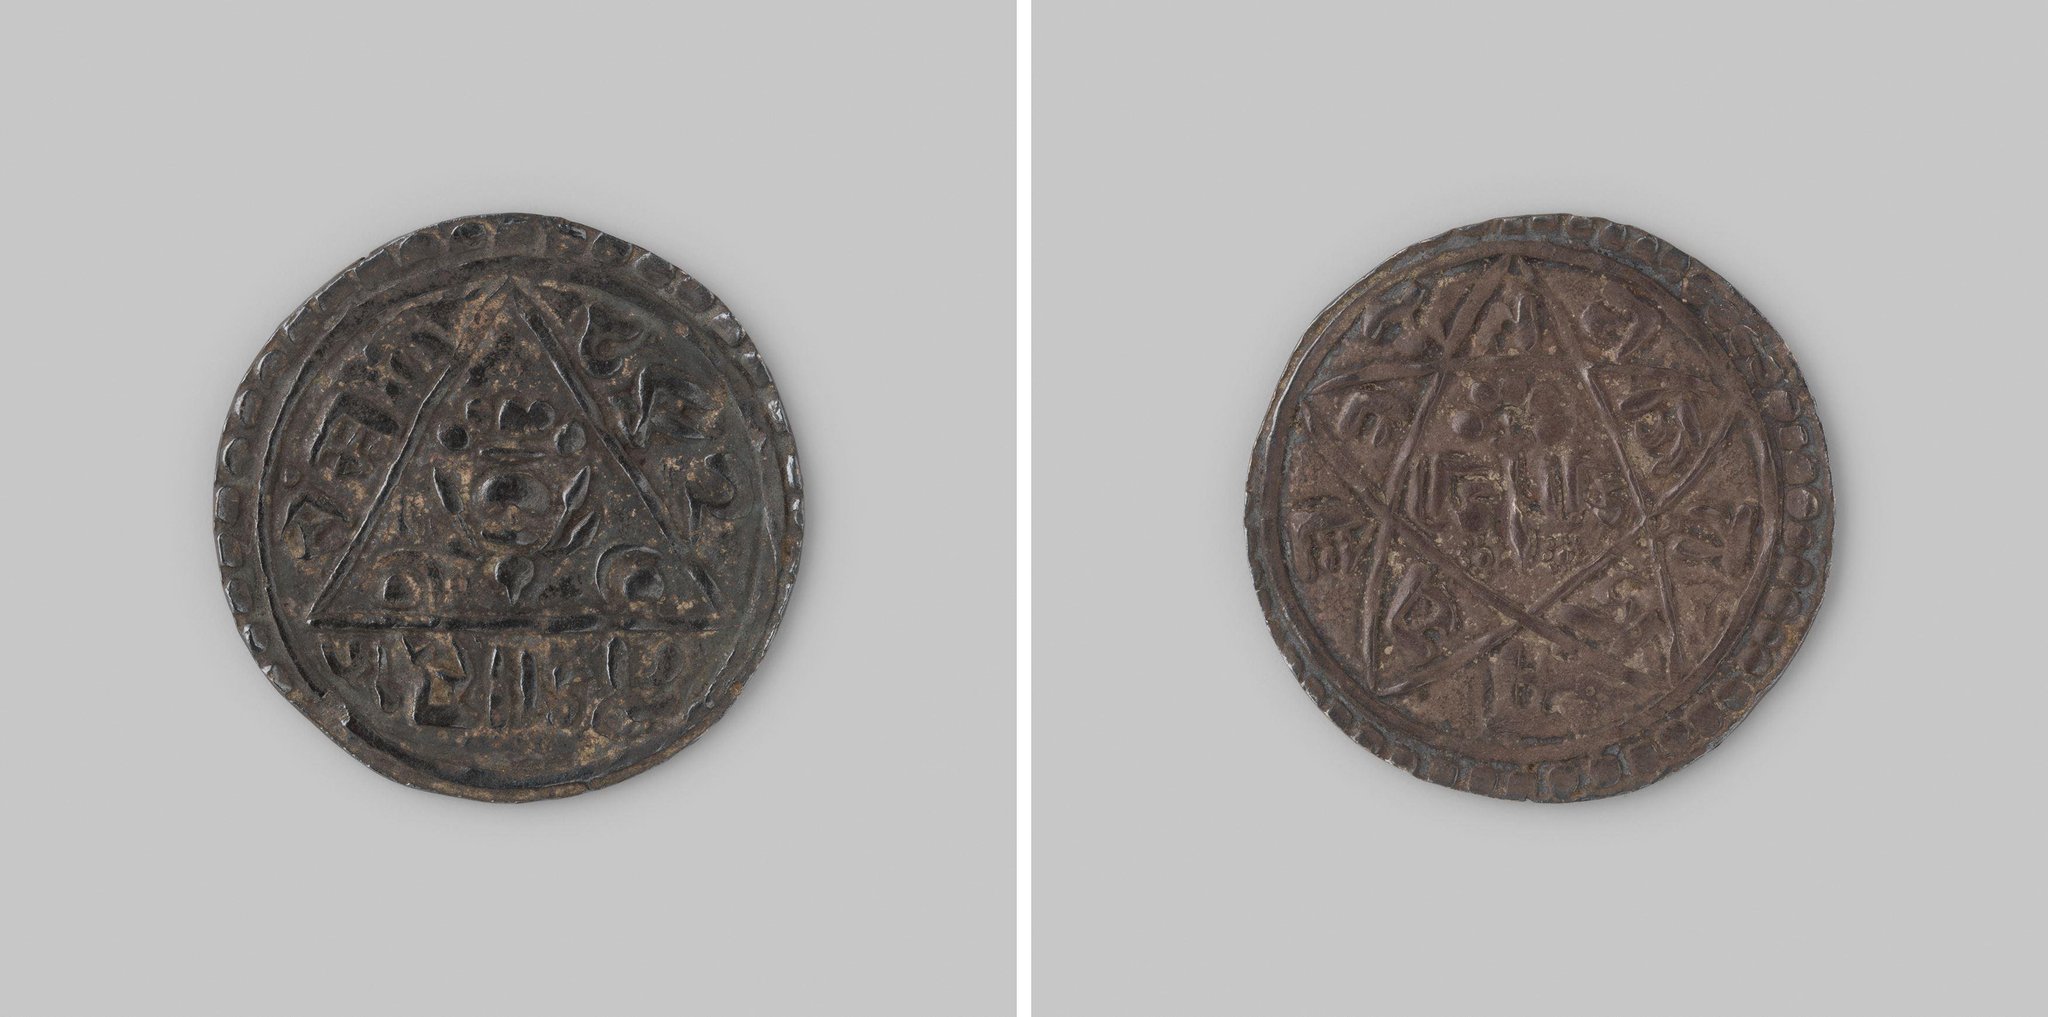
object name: coin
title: ½ mohar uit Nepal van Ranajit Malla van Bhatgaon, 842 [= 1722]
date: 1722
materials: silver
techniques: striking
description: Zilveren munt. Voorzijde: binnen een gelijkbenige driehoek met punt naar beneden ornamenten. Daaromheen tekens in Nagari-schrift jaartal in Nepalese cijfers: 842. Keerzijde: vijfpuntige ster-achtige figuur, waarin en waaromheen tekens in Nagari-schrift. Gladde rand.